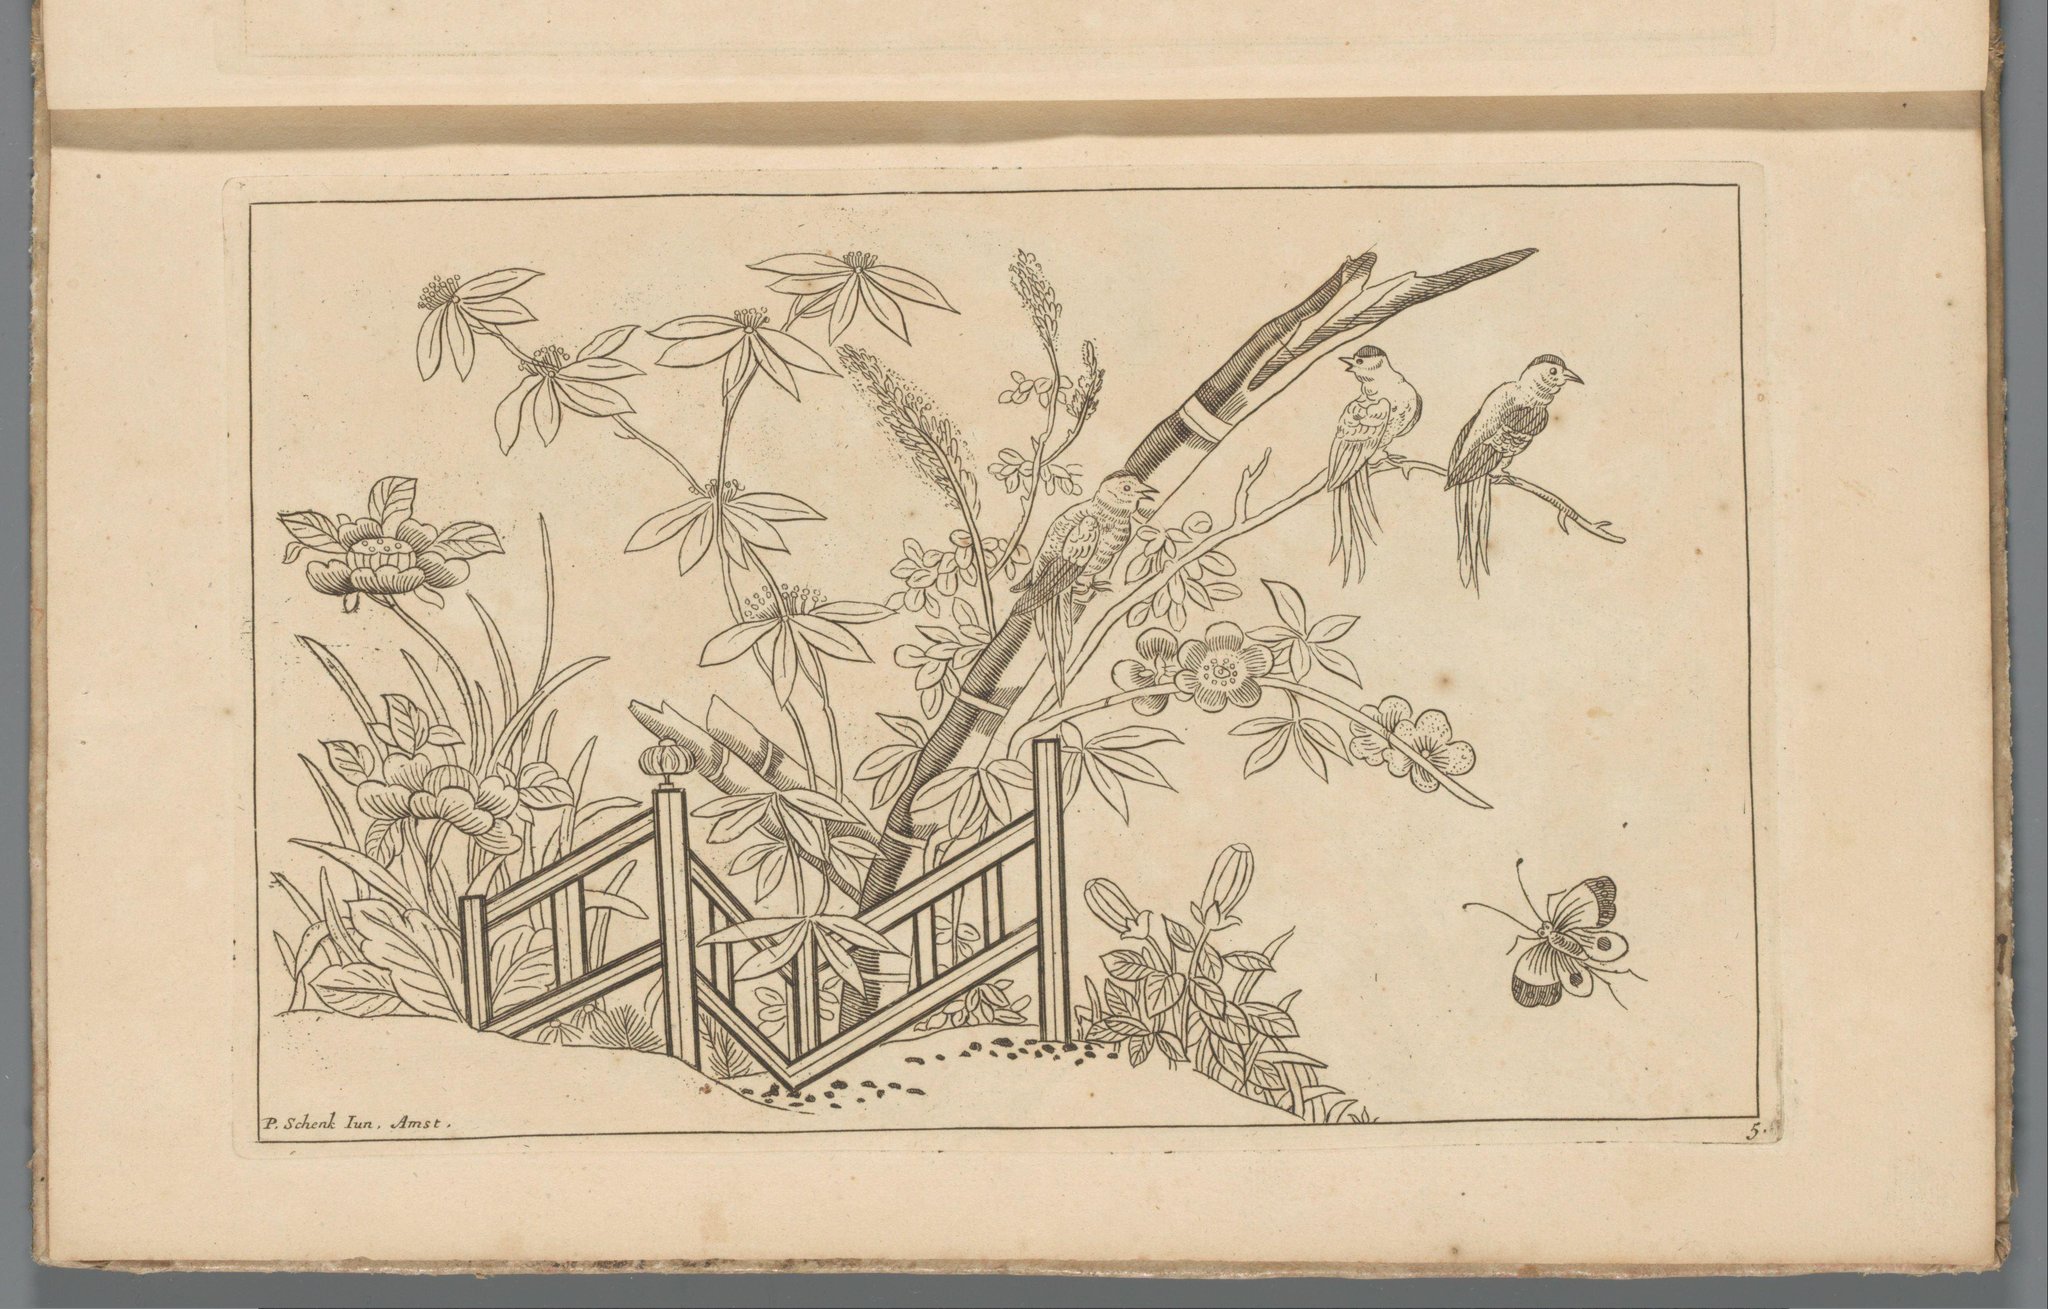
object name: ornament print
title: Chinese bloemen en vogels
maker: pieter schenk (ii)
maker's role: draughtsman, print maker, publisher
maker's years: 1693-1775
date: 1727-1775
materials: paper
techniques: etching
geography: amsterdam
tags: flowers, chinese, birds, insects: butterfly, trees (+ flowers, blossom, blossoming)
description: Drie vogels in een bloeiende boom. Aan de voet van de boom een hek. Rechts een vlinder. Prent maakt deel uit van een album.